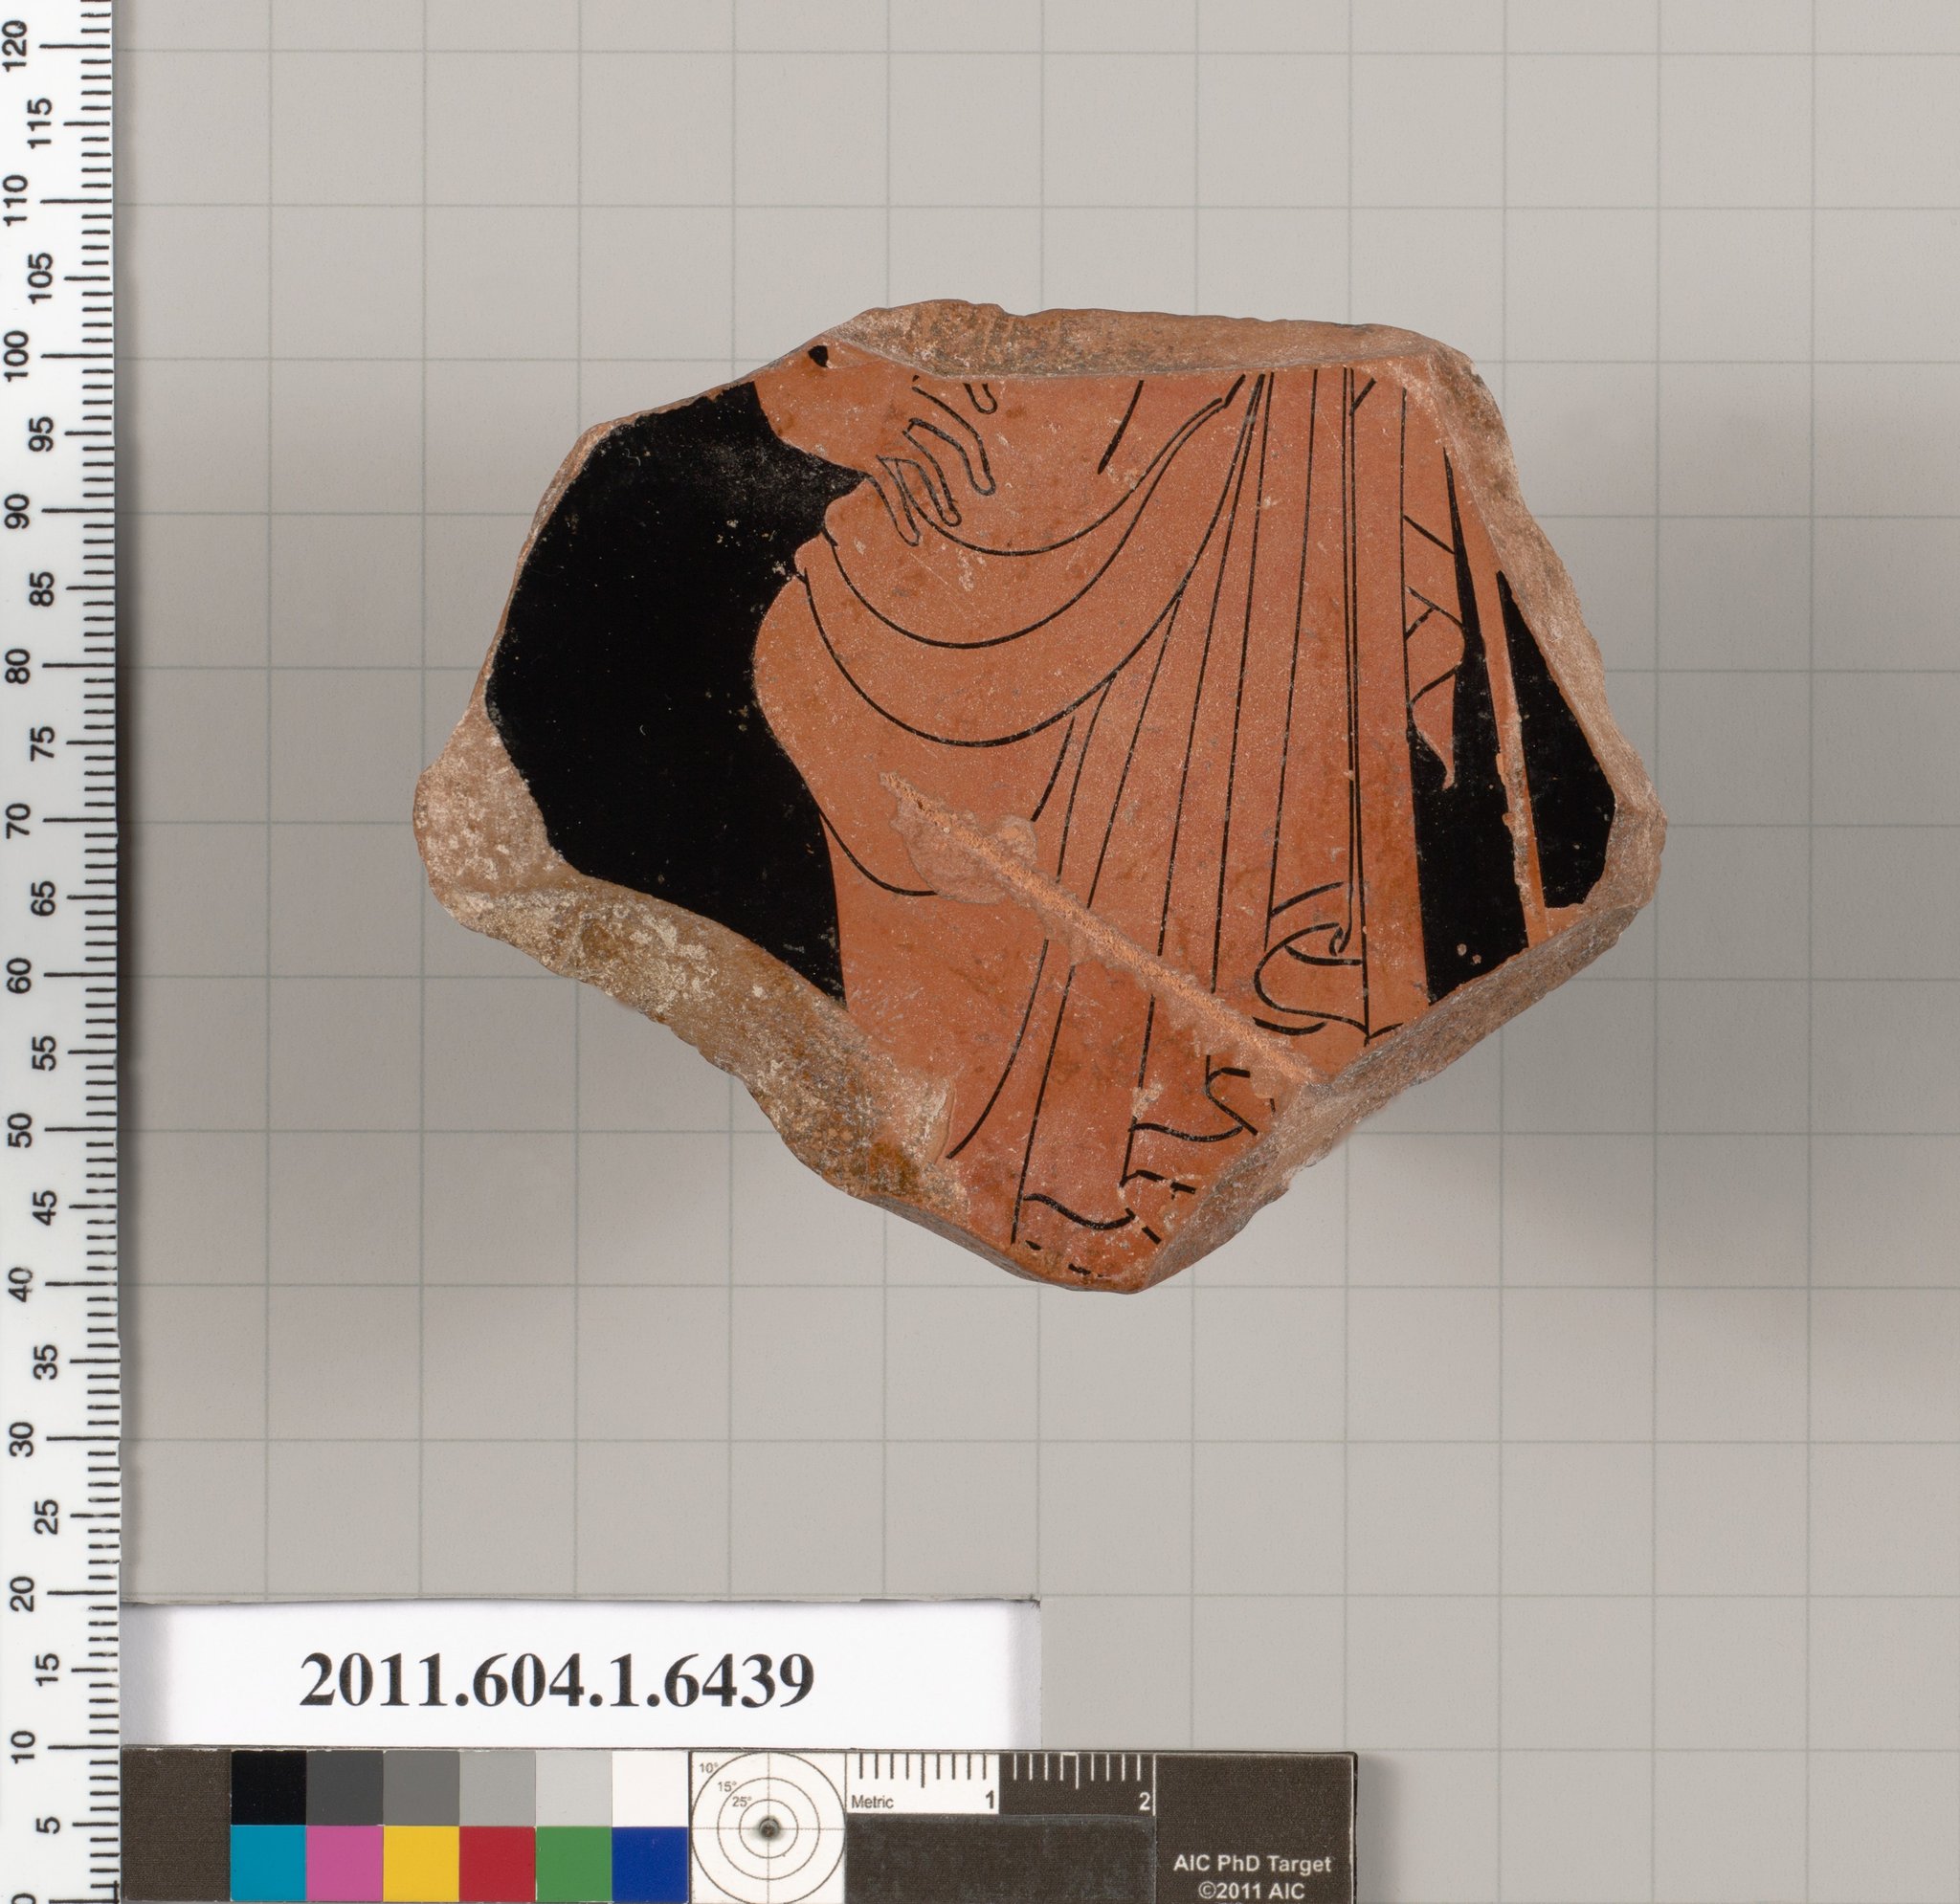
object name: kylix fragment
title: Terracotta fragment of a kylix (drinking cup)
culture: greek, attic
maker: antiphon painter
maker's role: artist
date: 490-480 BCE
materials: terracotta